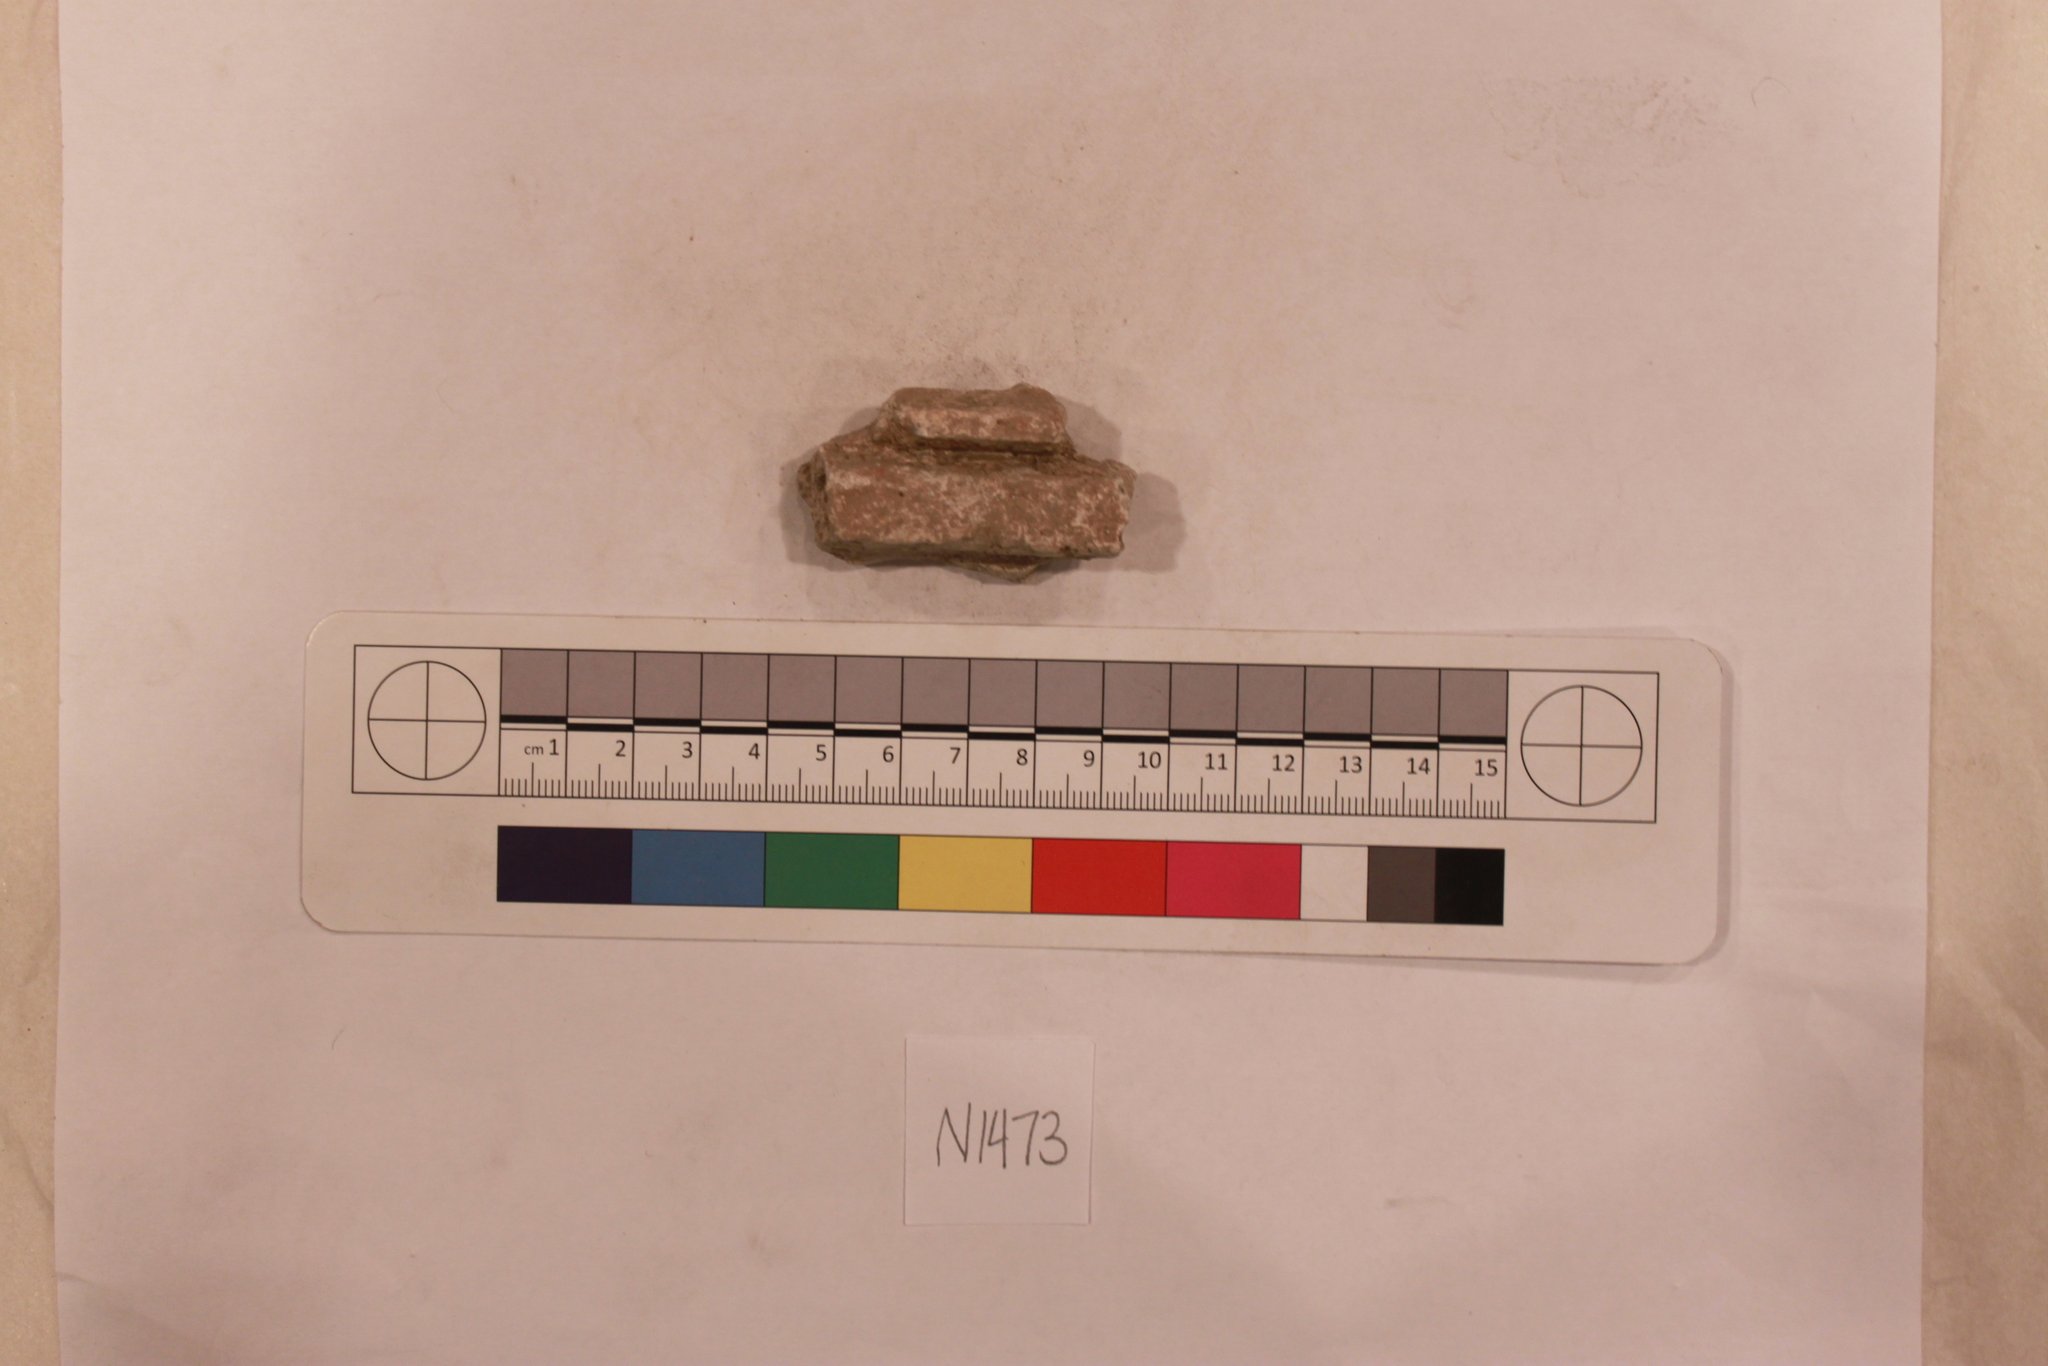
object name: fragment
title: Stucco Fragment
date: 701-1200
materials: plaster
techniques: carving, painting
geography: iran